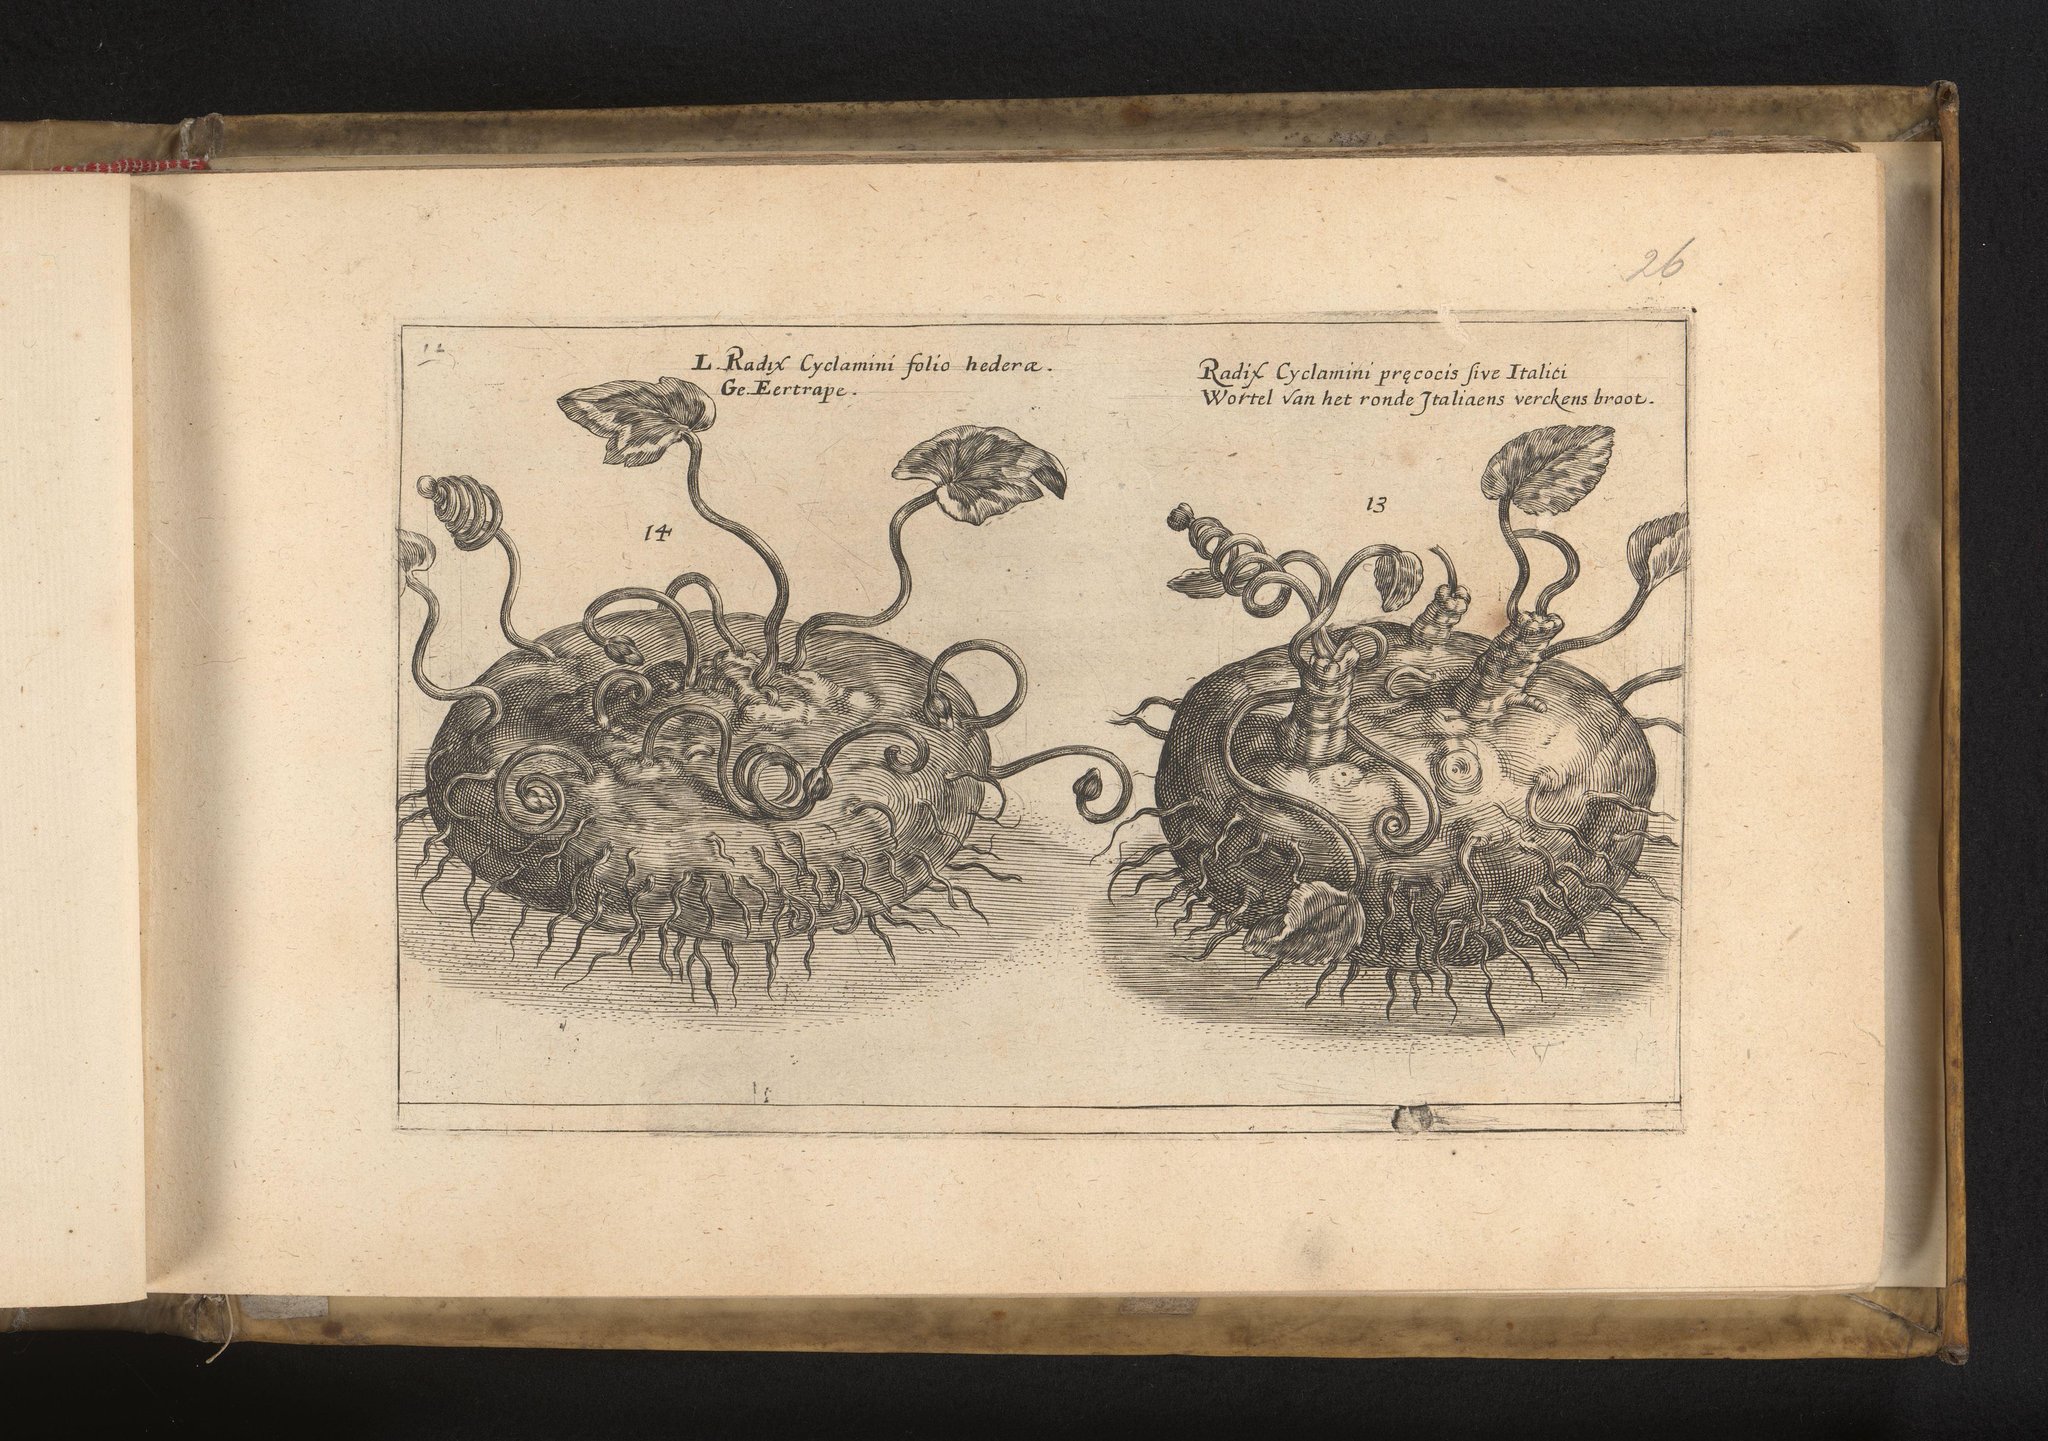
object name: book illustration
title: Radix cyclamini precocis sive Italici / Wortel van het ronde Italiaens verckens broot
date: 1617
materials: paper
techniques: engraving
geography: utrecht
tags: flowers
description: Prent uit: Passe, Crispijn van de (II). Hortus floridus in quo rariorum & minus vulgarium florum icones ad vivam veramque formam. Arnhem: Johannes Janssonius, 1617. Deze prent, hoewel onderdeel van het deel van het deel over herfstbloemen, valt buiten de nummering. Niettemin is de tekst behorende bij deze prent gedrukt op het verso van prent 25 in de serie.